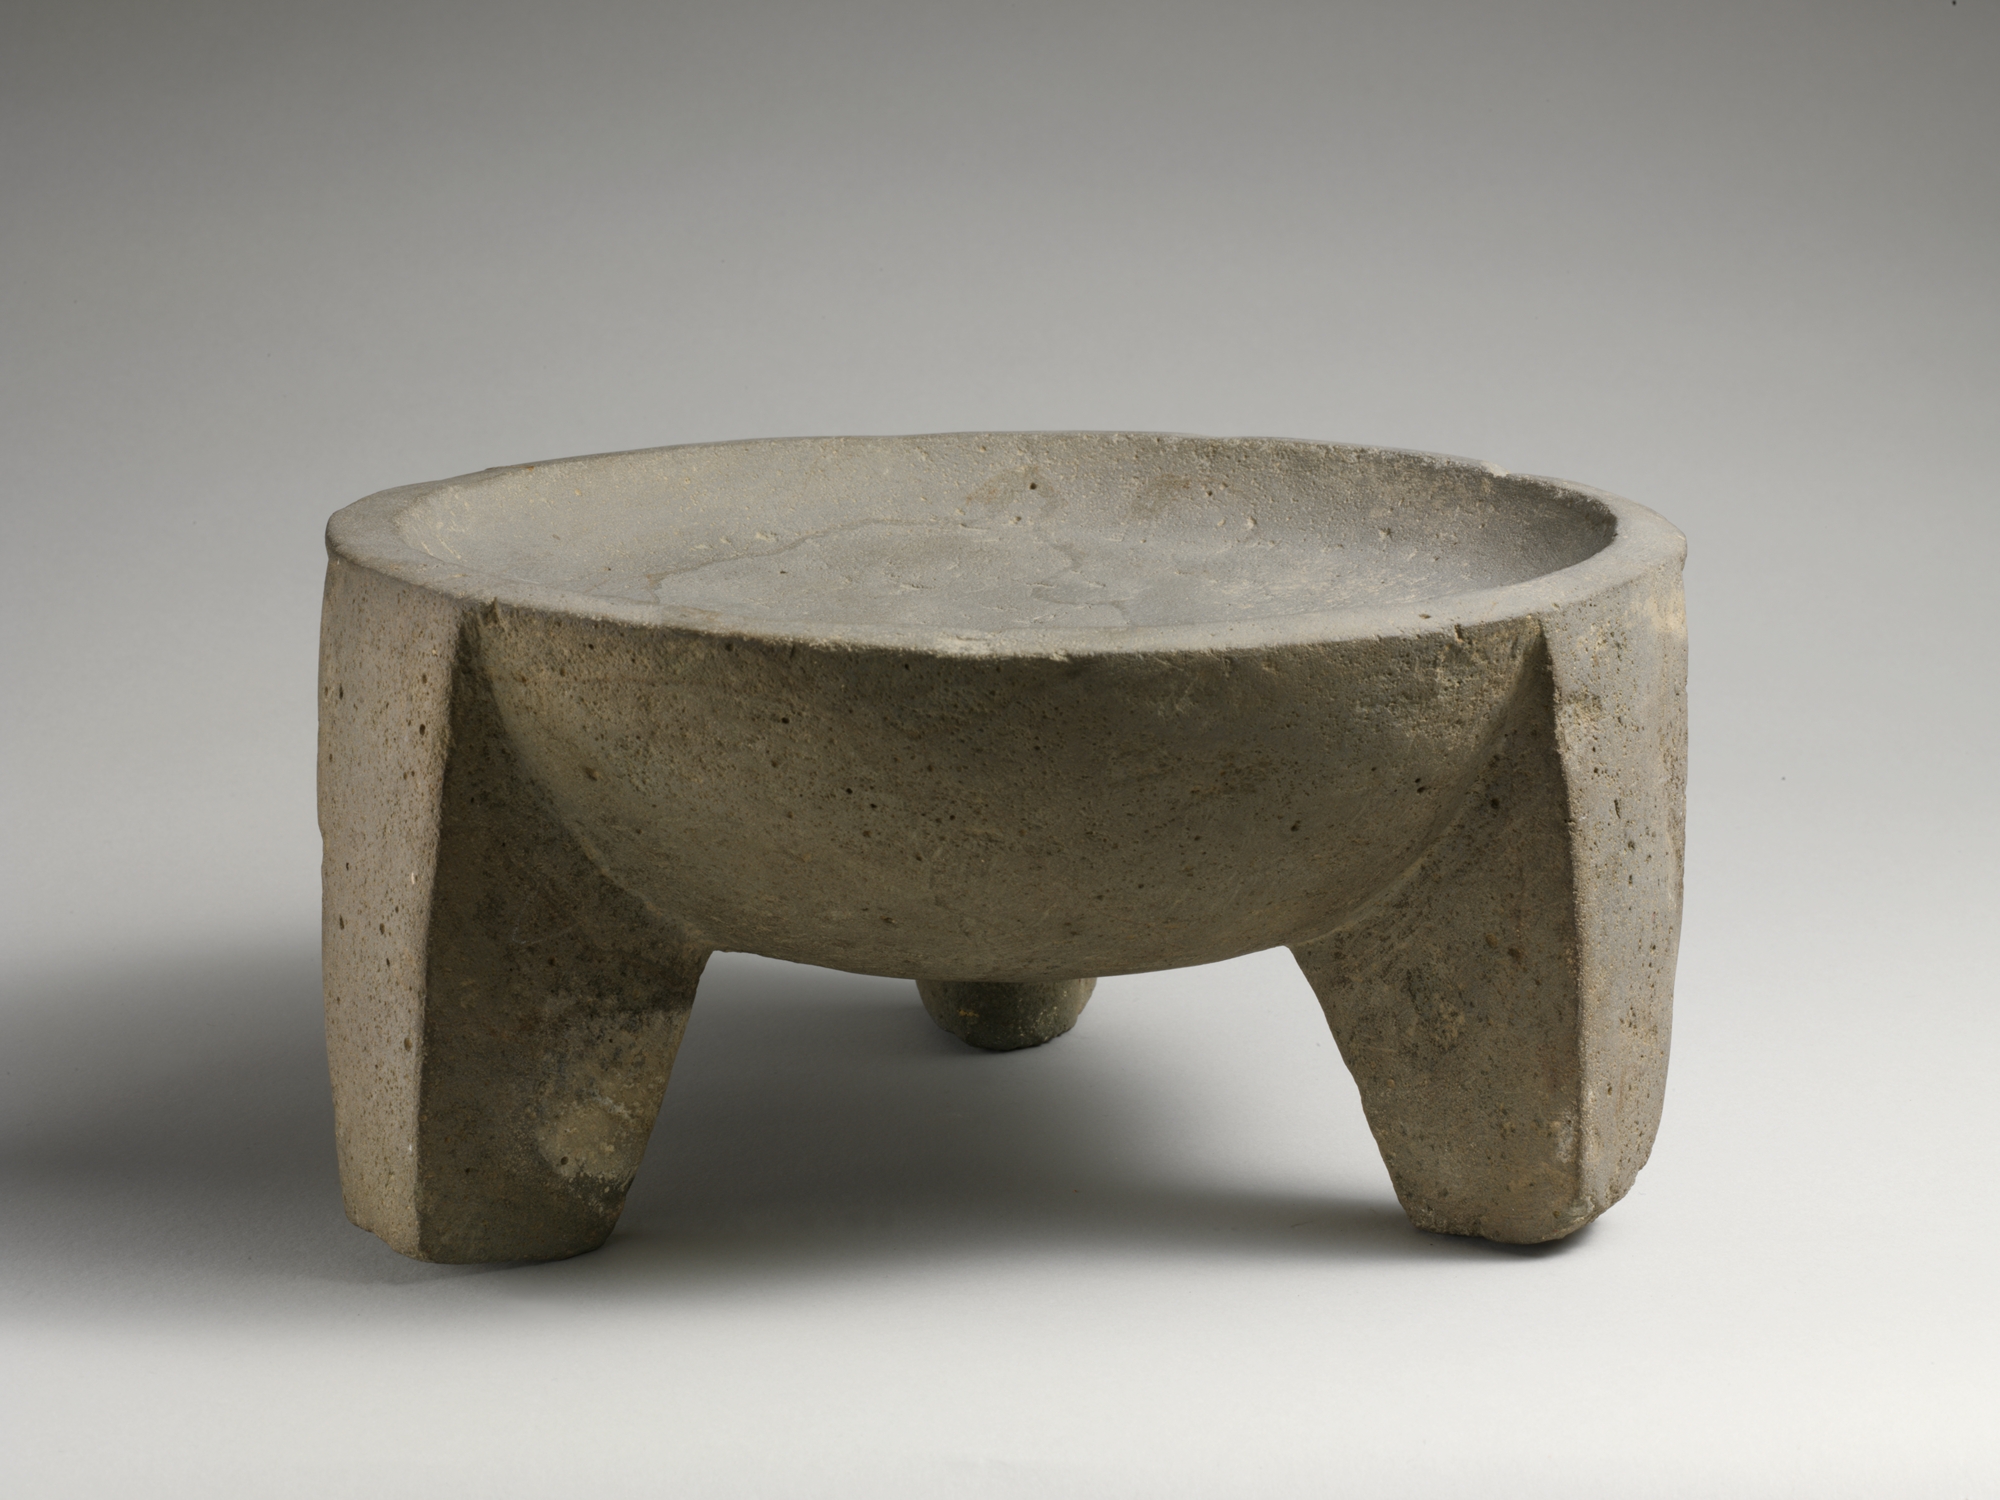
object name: bowl, shallow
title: Basalt tripod vessel or mortar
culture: cypriot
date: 2500-1050 BCE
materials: stone